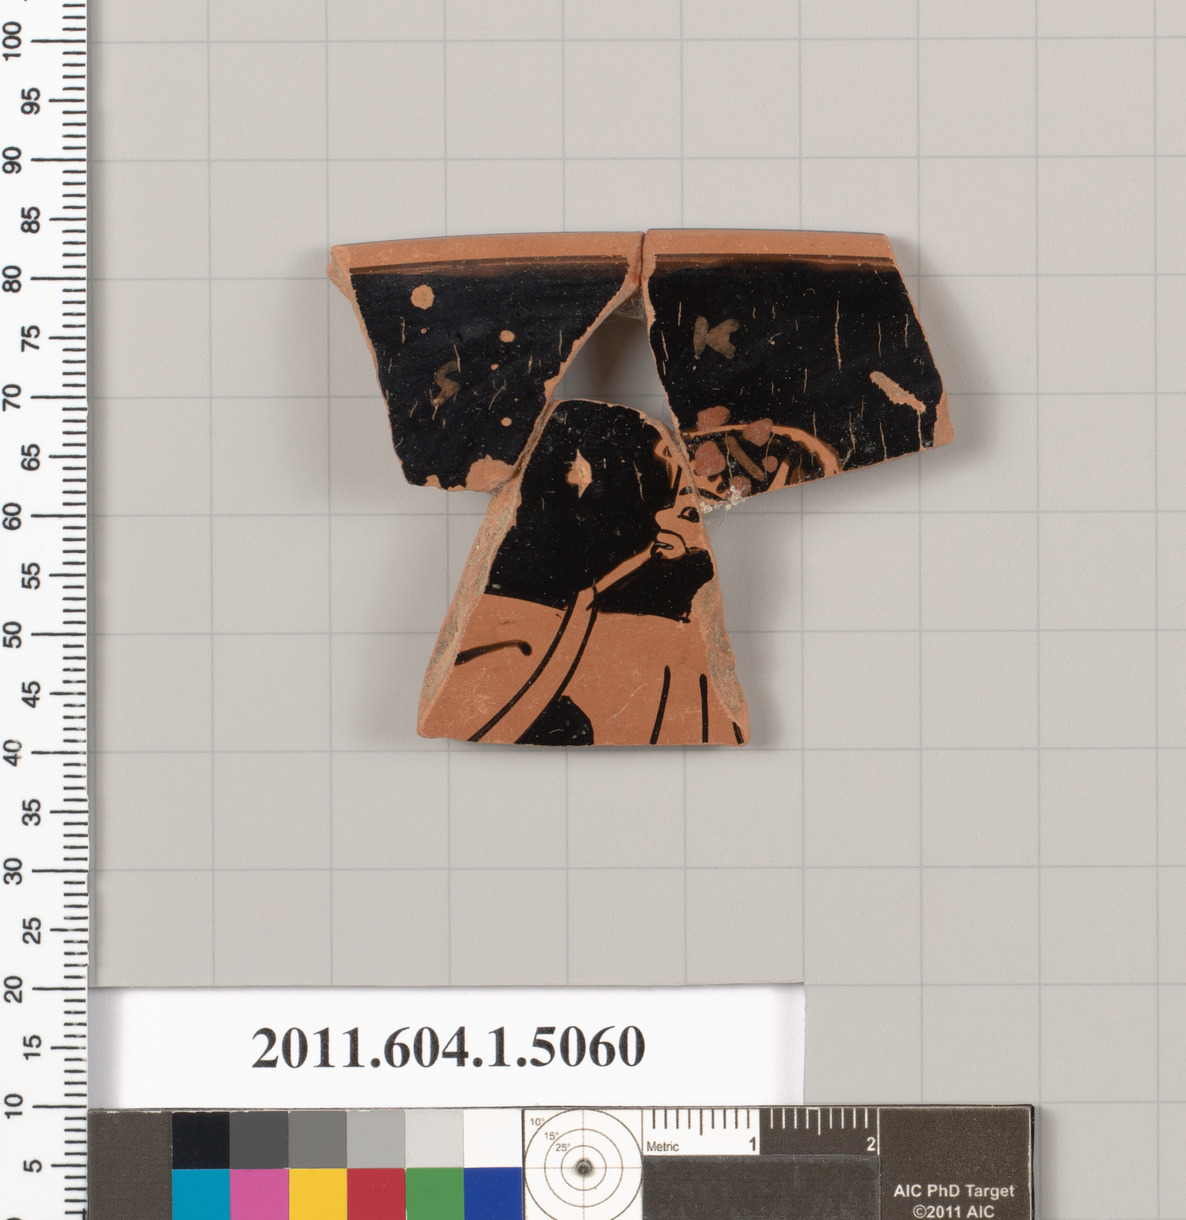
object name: kylix fragment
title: Terracotta rim fragment of a kylix (drinking cup)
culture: greek, attic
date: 534-468 BCE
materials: terracotta